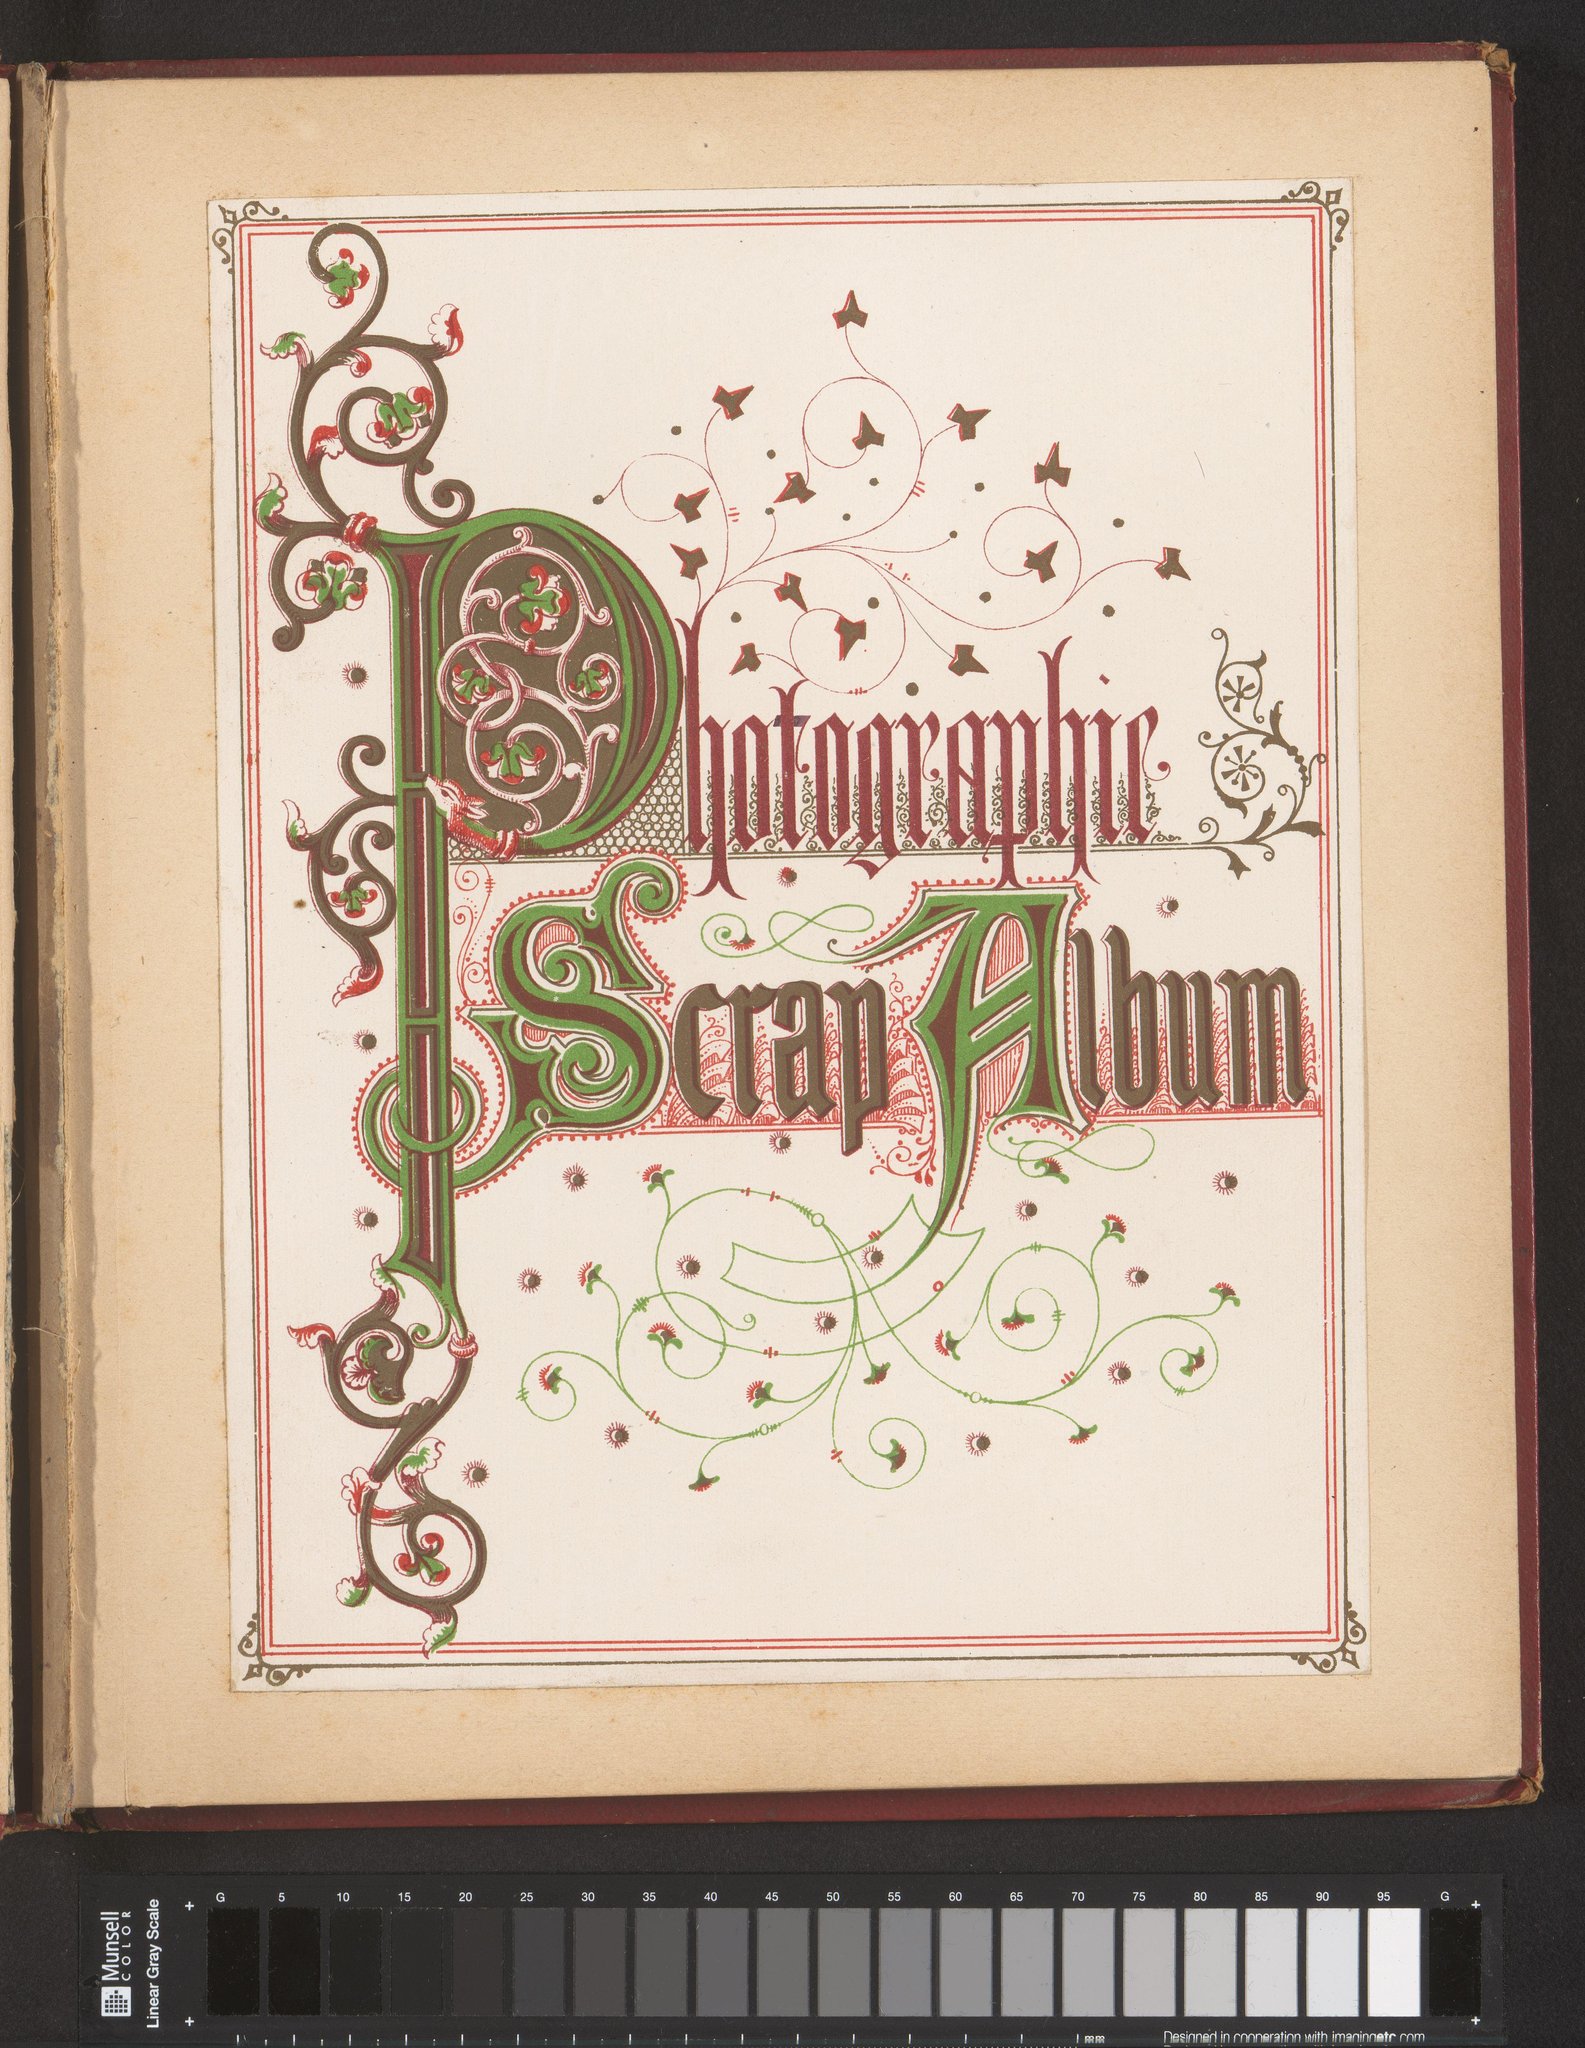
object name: scrapbook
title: Photographie Scrap Album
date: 1875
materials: cardboard, leather, paper, photographic support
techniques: albumen print, woodburytype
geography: england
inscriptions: annotation: ‘Ada Louisa Taylor/ With her father's & morther's fond love & best ... wishes/ 1875’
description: Fotoalbum met 28 bladen met in totaal 61 foto's. Tussen de eerste 3 bladen zit vloeipapier. Los in een envelop bevinden zich nog eens 21 losse foto’s. Het album bevat een verzameling fotografische reproducties van gravures naar schilderijen. Werken van onder andere John Everett Millais, Edwin Henry Landseer en Eduard Grützner. De fotograaf van de afbeeldingen is anoniem. Sommige pagina's zijn voorzien van decoraties en niet op alle pagina's zitten foto's geplakt.